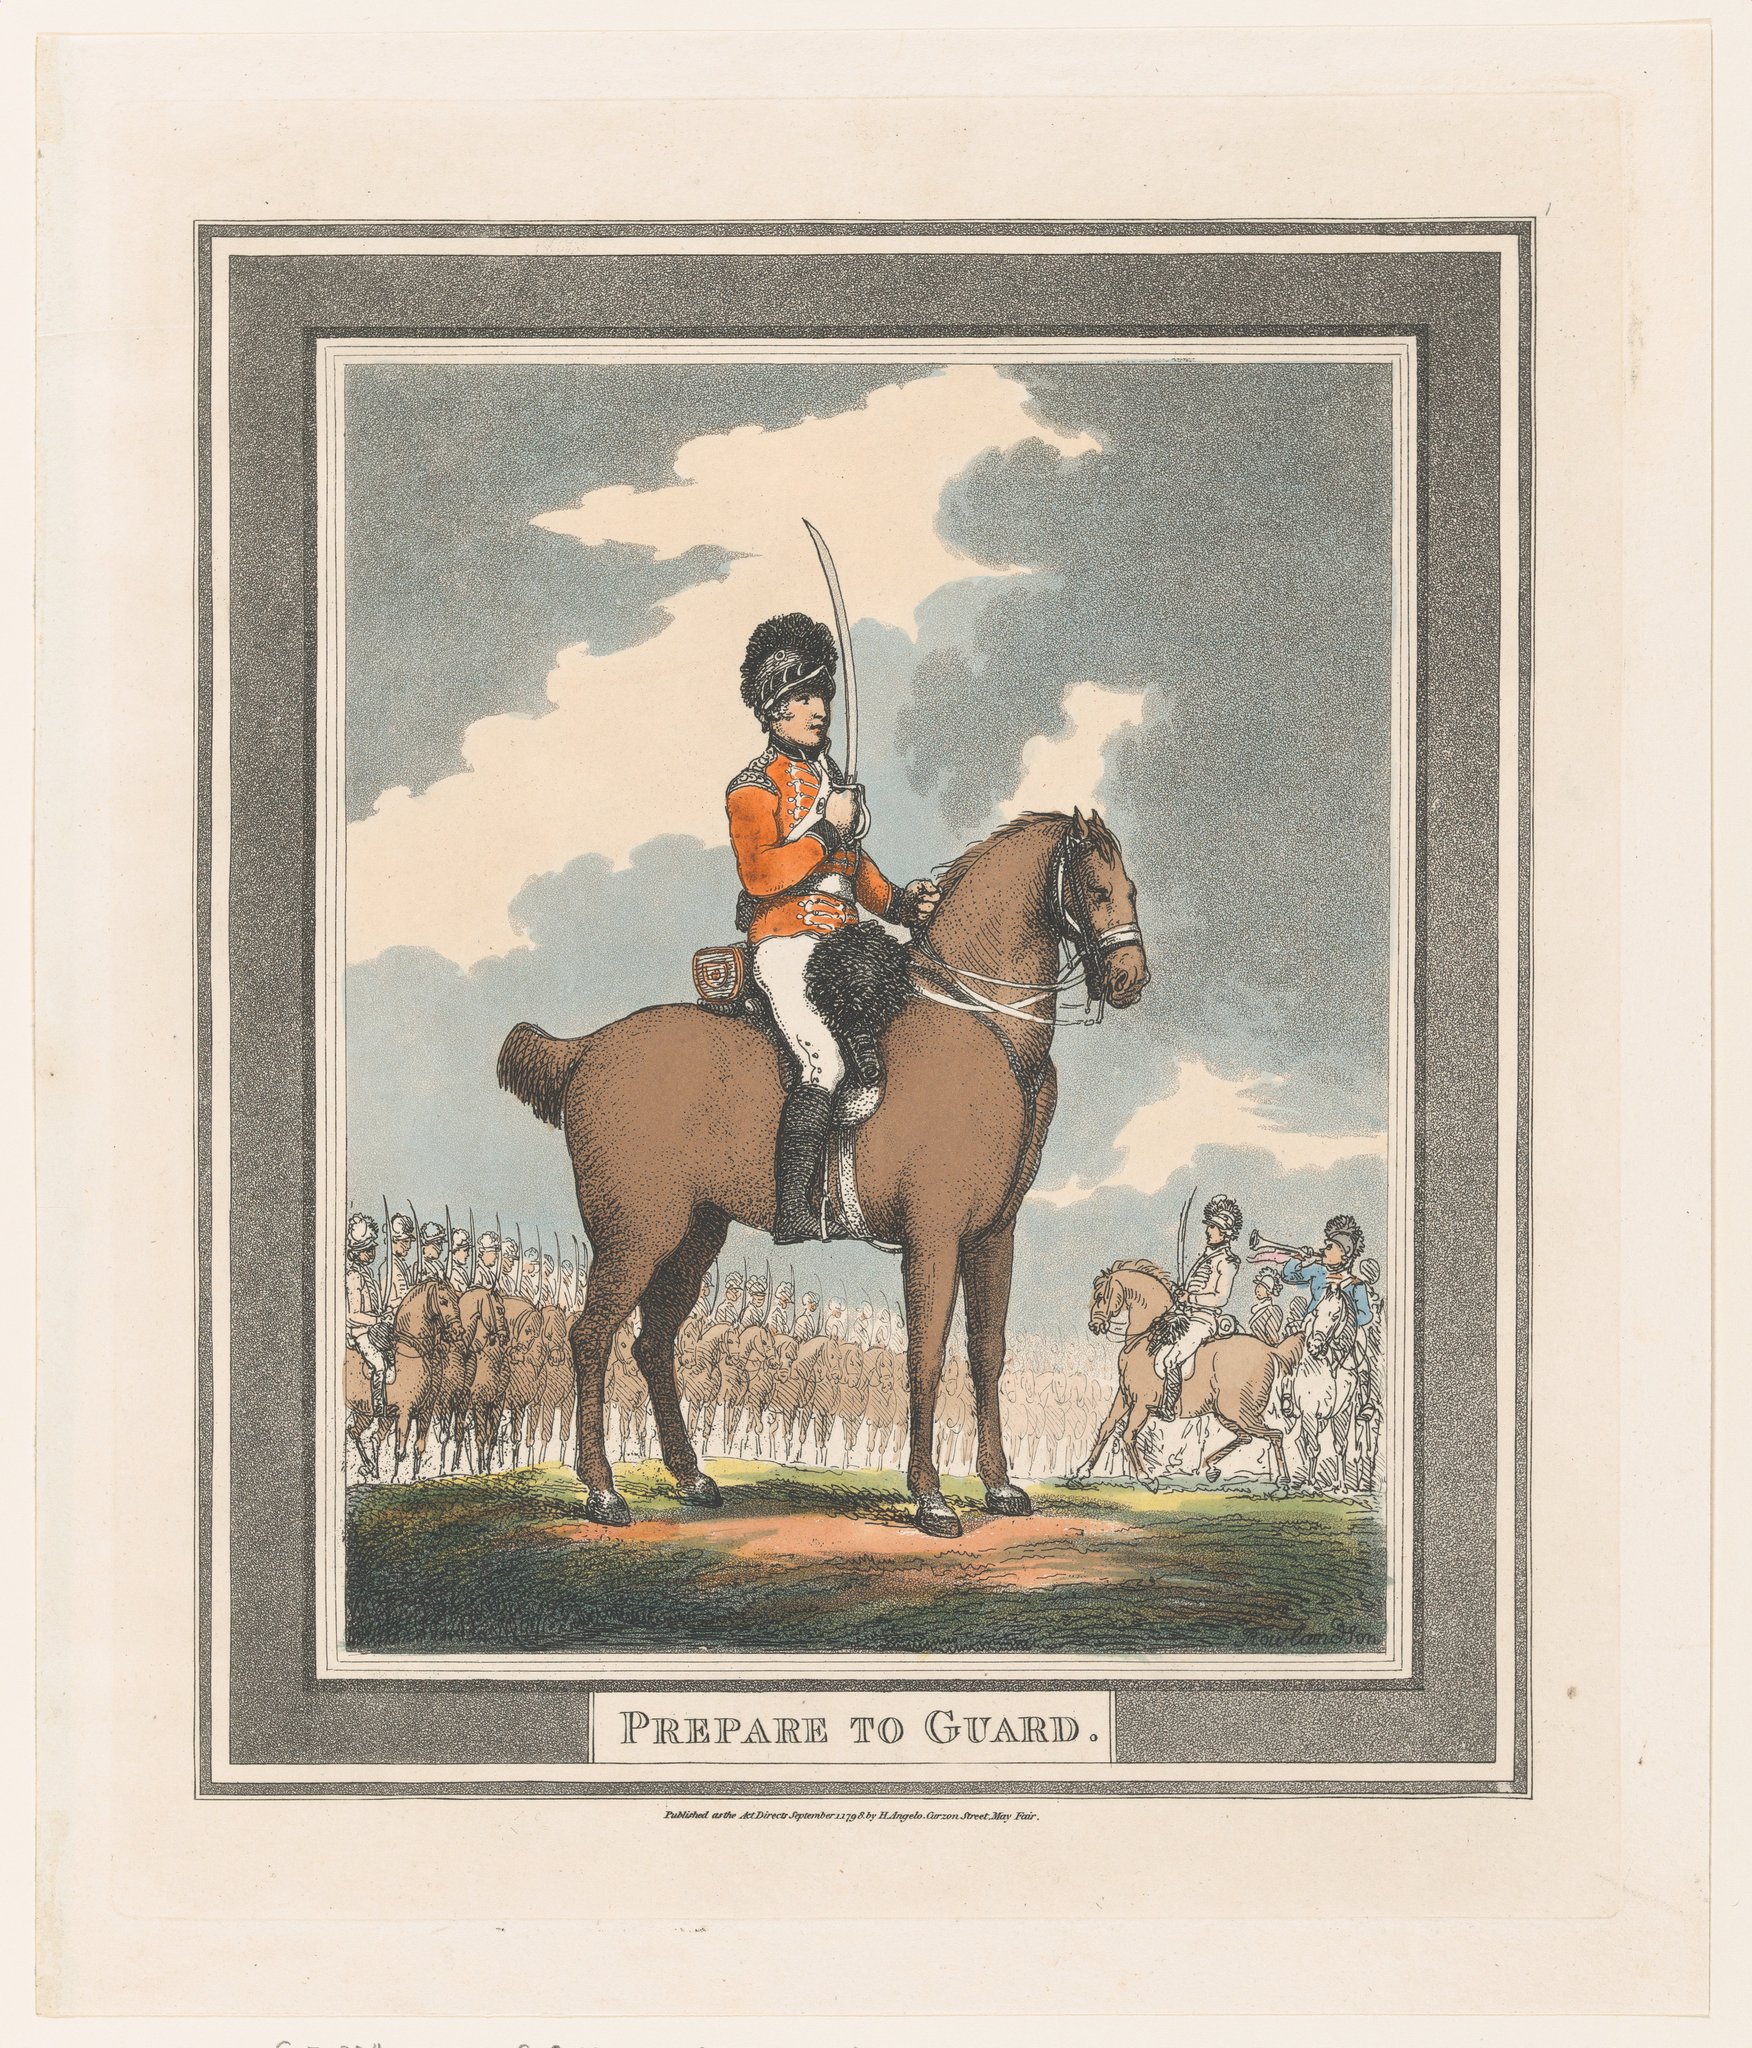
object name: print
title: Prepare to Guard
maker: thomas rowlandson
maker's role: artist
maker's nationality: british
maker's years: 1757-1827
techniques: aquatint, etching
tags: soldiers,men,horses